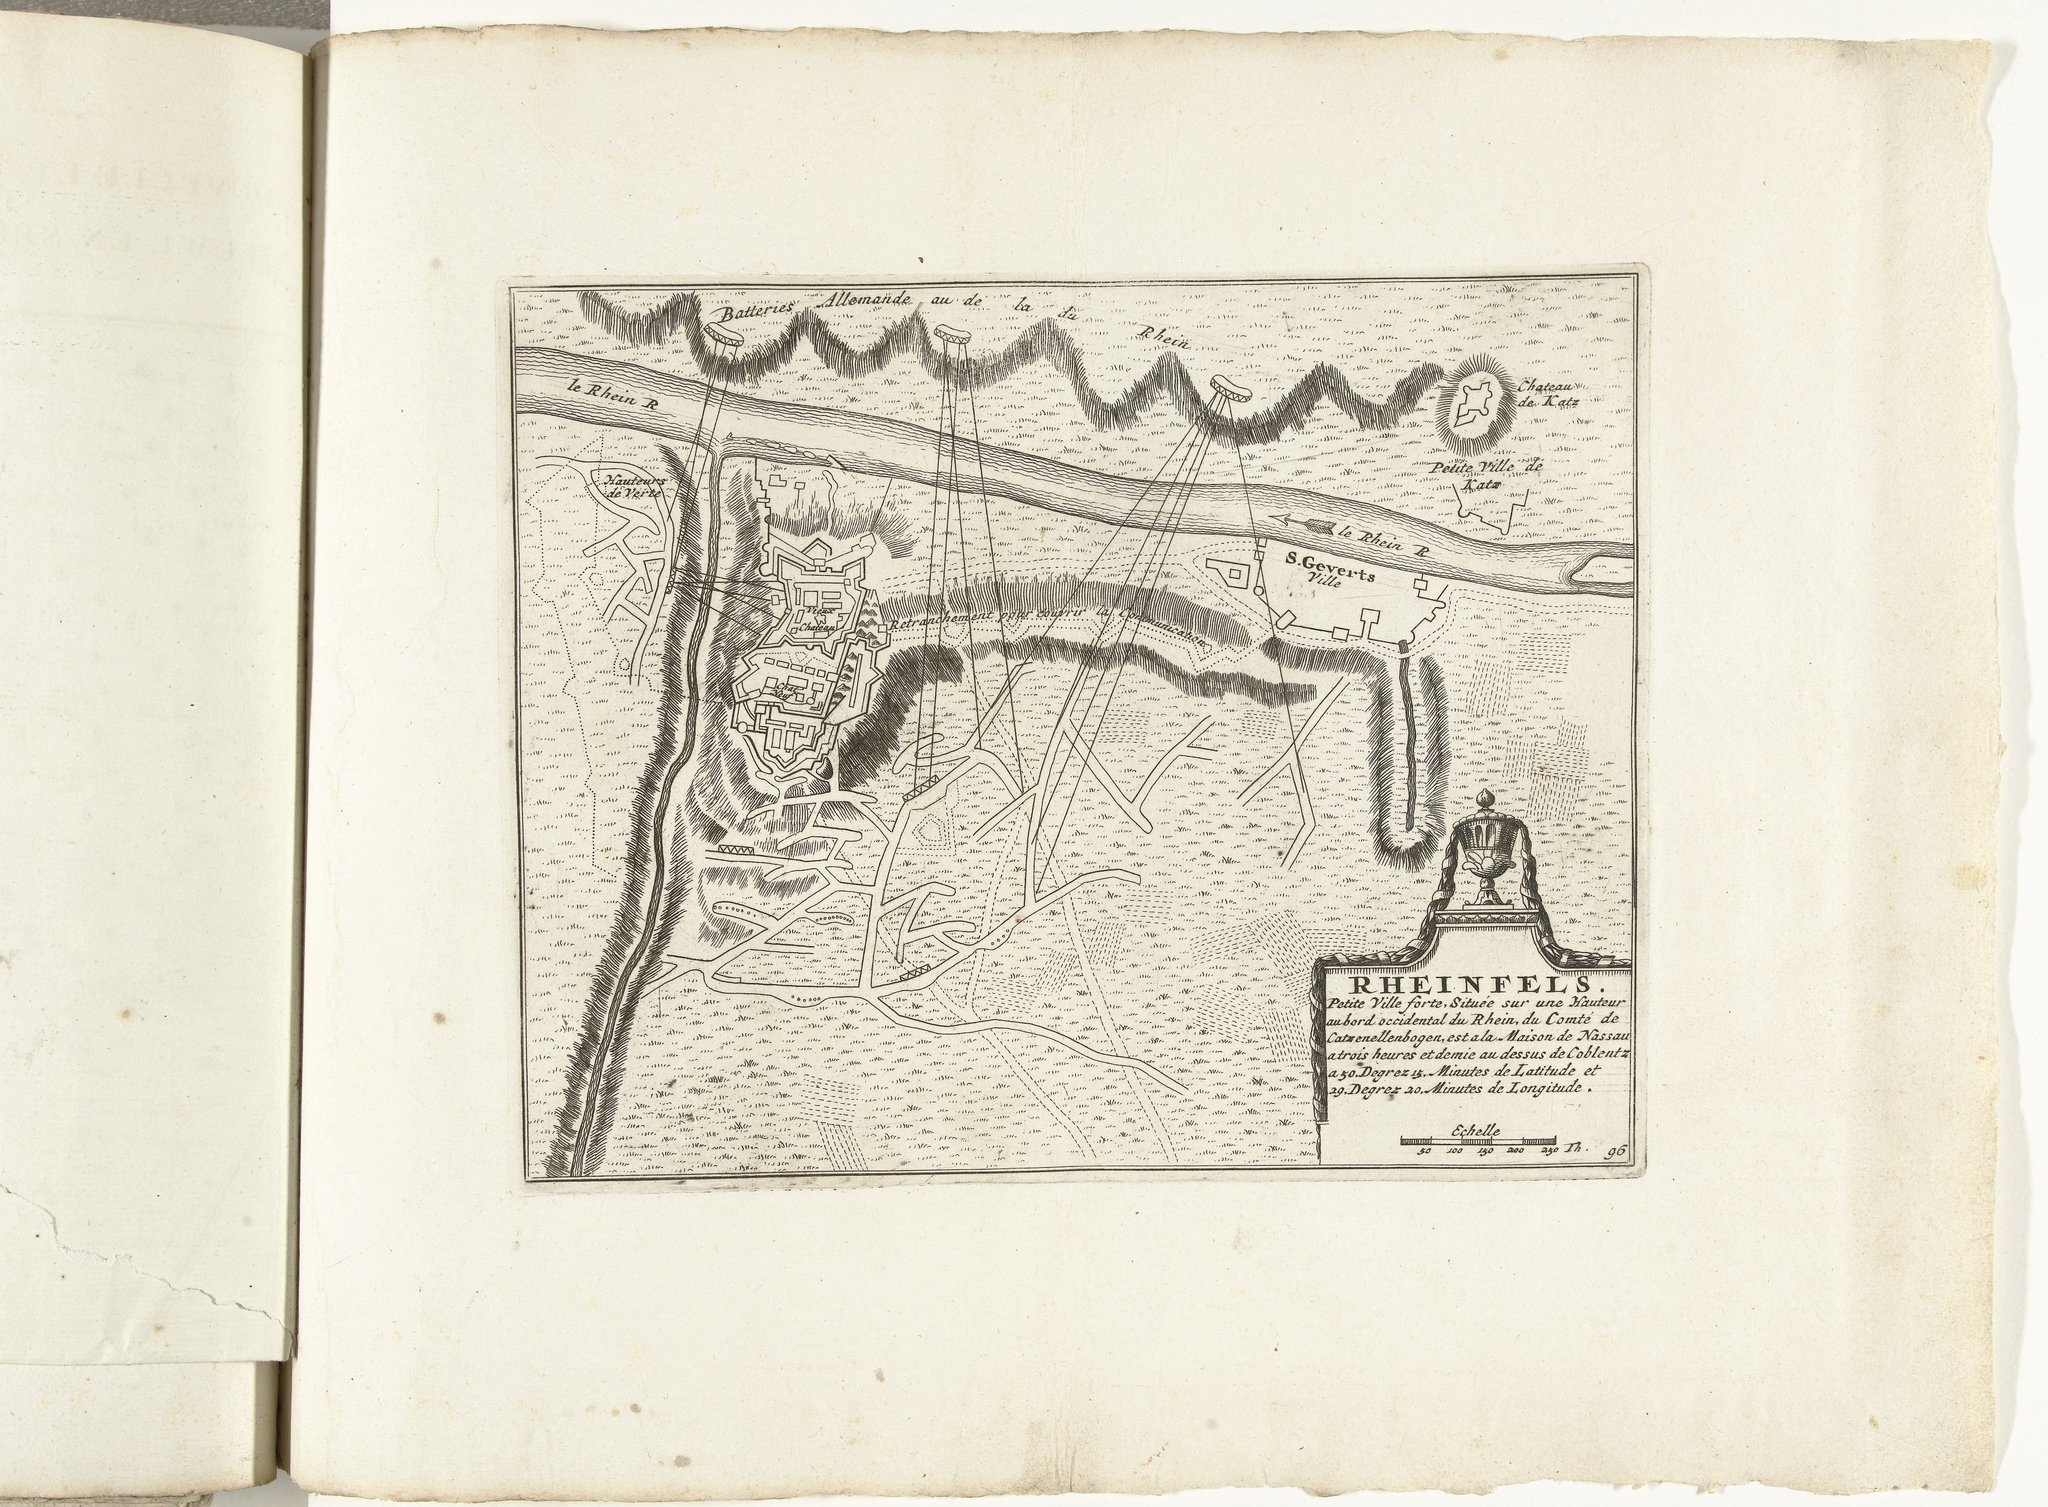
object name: map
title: Plattegrond met het ontzet van Rheinfels, 1693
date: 1702-1703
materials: paper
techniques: etching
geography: northern netherlands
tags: raising the siege with outside assistance, relief, maps of cities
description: Plattegrond met het ontzet van Rheinfels (dat belegerd werd door de Fransen) door Duitse troepen, januari 1693. Plaat nr. 96 in het prentwerk bestaande in totaal uit 276 genummerde platen van vermaarde sterke steden en vestingen in het kader van de Spaanse Successieoorlog. Voor het merendeel zijn deze platen gekopieerd naar de anonieme Franse platen: in Les forces de l'Europe en in: Le theatre de la guerre, dans les Pays-Bas, beide oorspronkelijk uitgegeven door Nicolas de Fer te Parijs (1693-1697) in het kader van de Negenjarige Oorlog. Titel en opschriften in de plaat in het Frans.